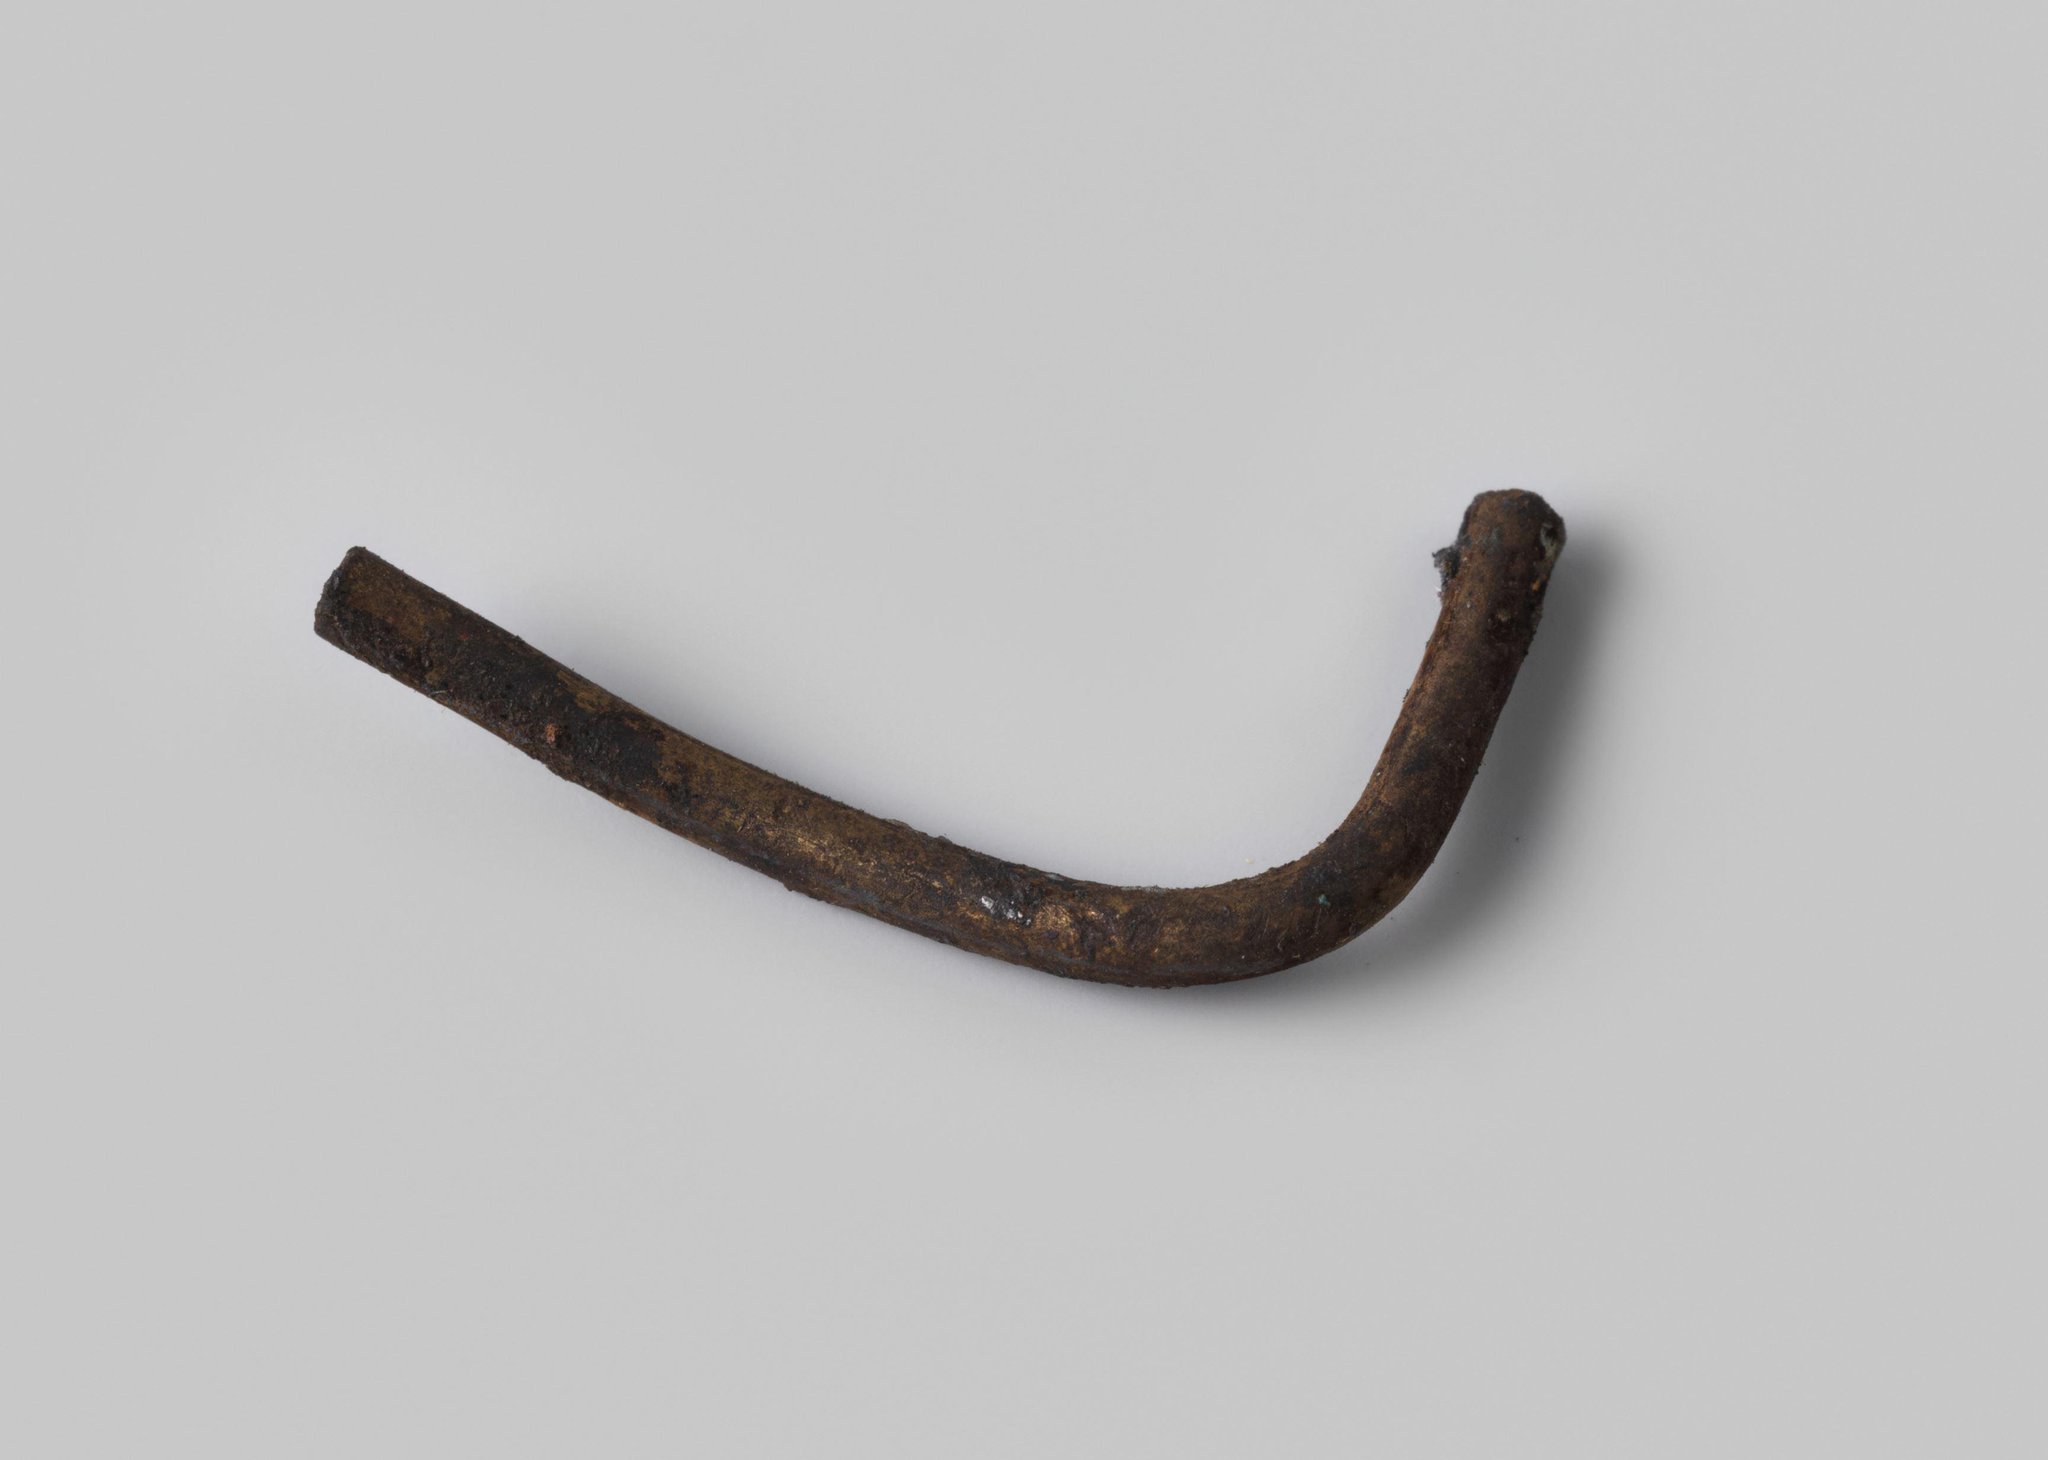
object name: wire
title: Koperdraad uit het wrak van de Oost-Indiëvaarder Hollandia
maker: Anonymous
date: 1700-1743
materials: copper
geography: netherlands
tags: verenigde oostindische compagnie, hollandia (schip), annet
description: Varied parts or fragments, wire; fragm, bent, circular in section.